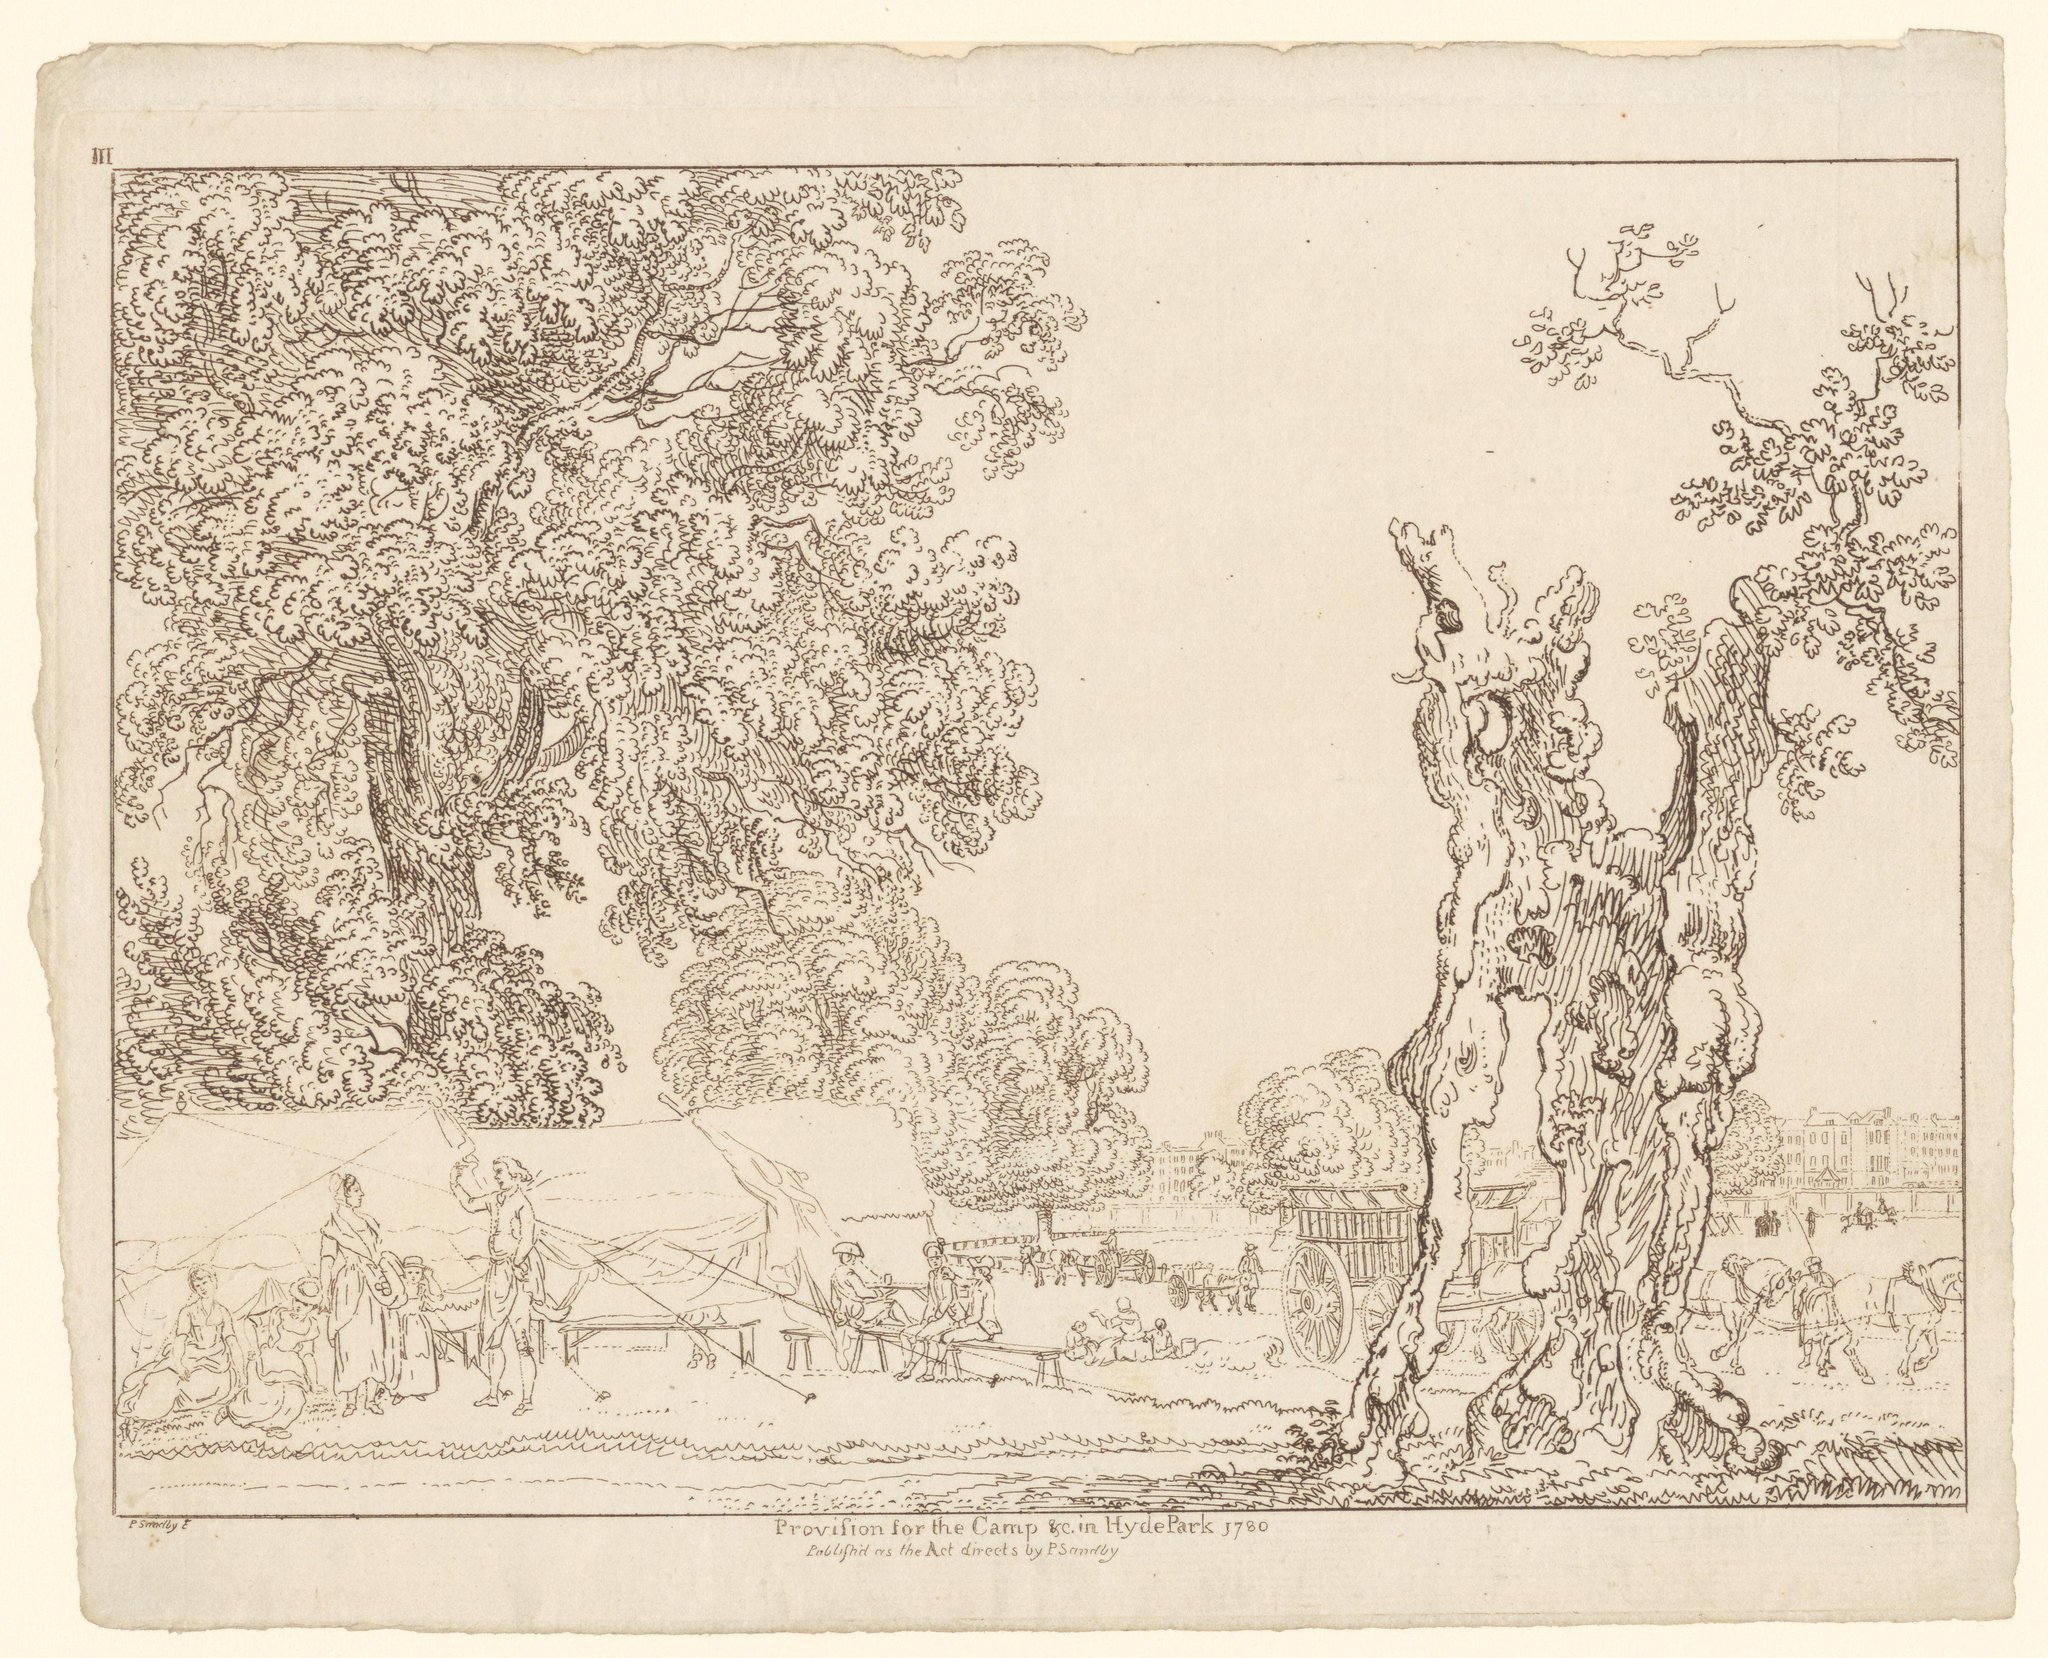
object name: print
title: Ten View of Encampements in Hyde-Park and Blackheath II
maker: paul sandby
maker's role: draughtsman, print maker, publisher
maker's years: 1725-1809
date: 1780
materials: paper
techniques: etching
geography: london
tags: trees, (military) camp with tents, public gardens, park (+ city(-scape) with figures, staffage)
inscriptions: collector's mark: Lugt 2228